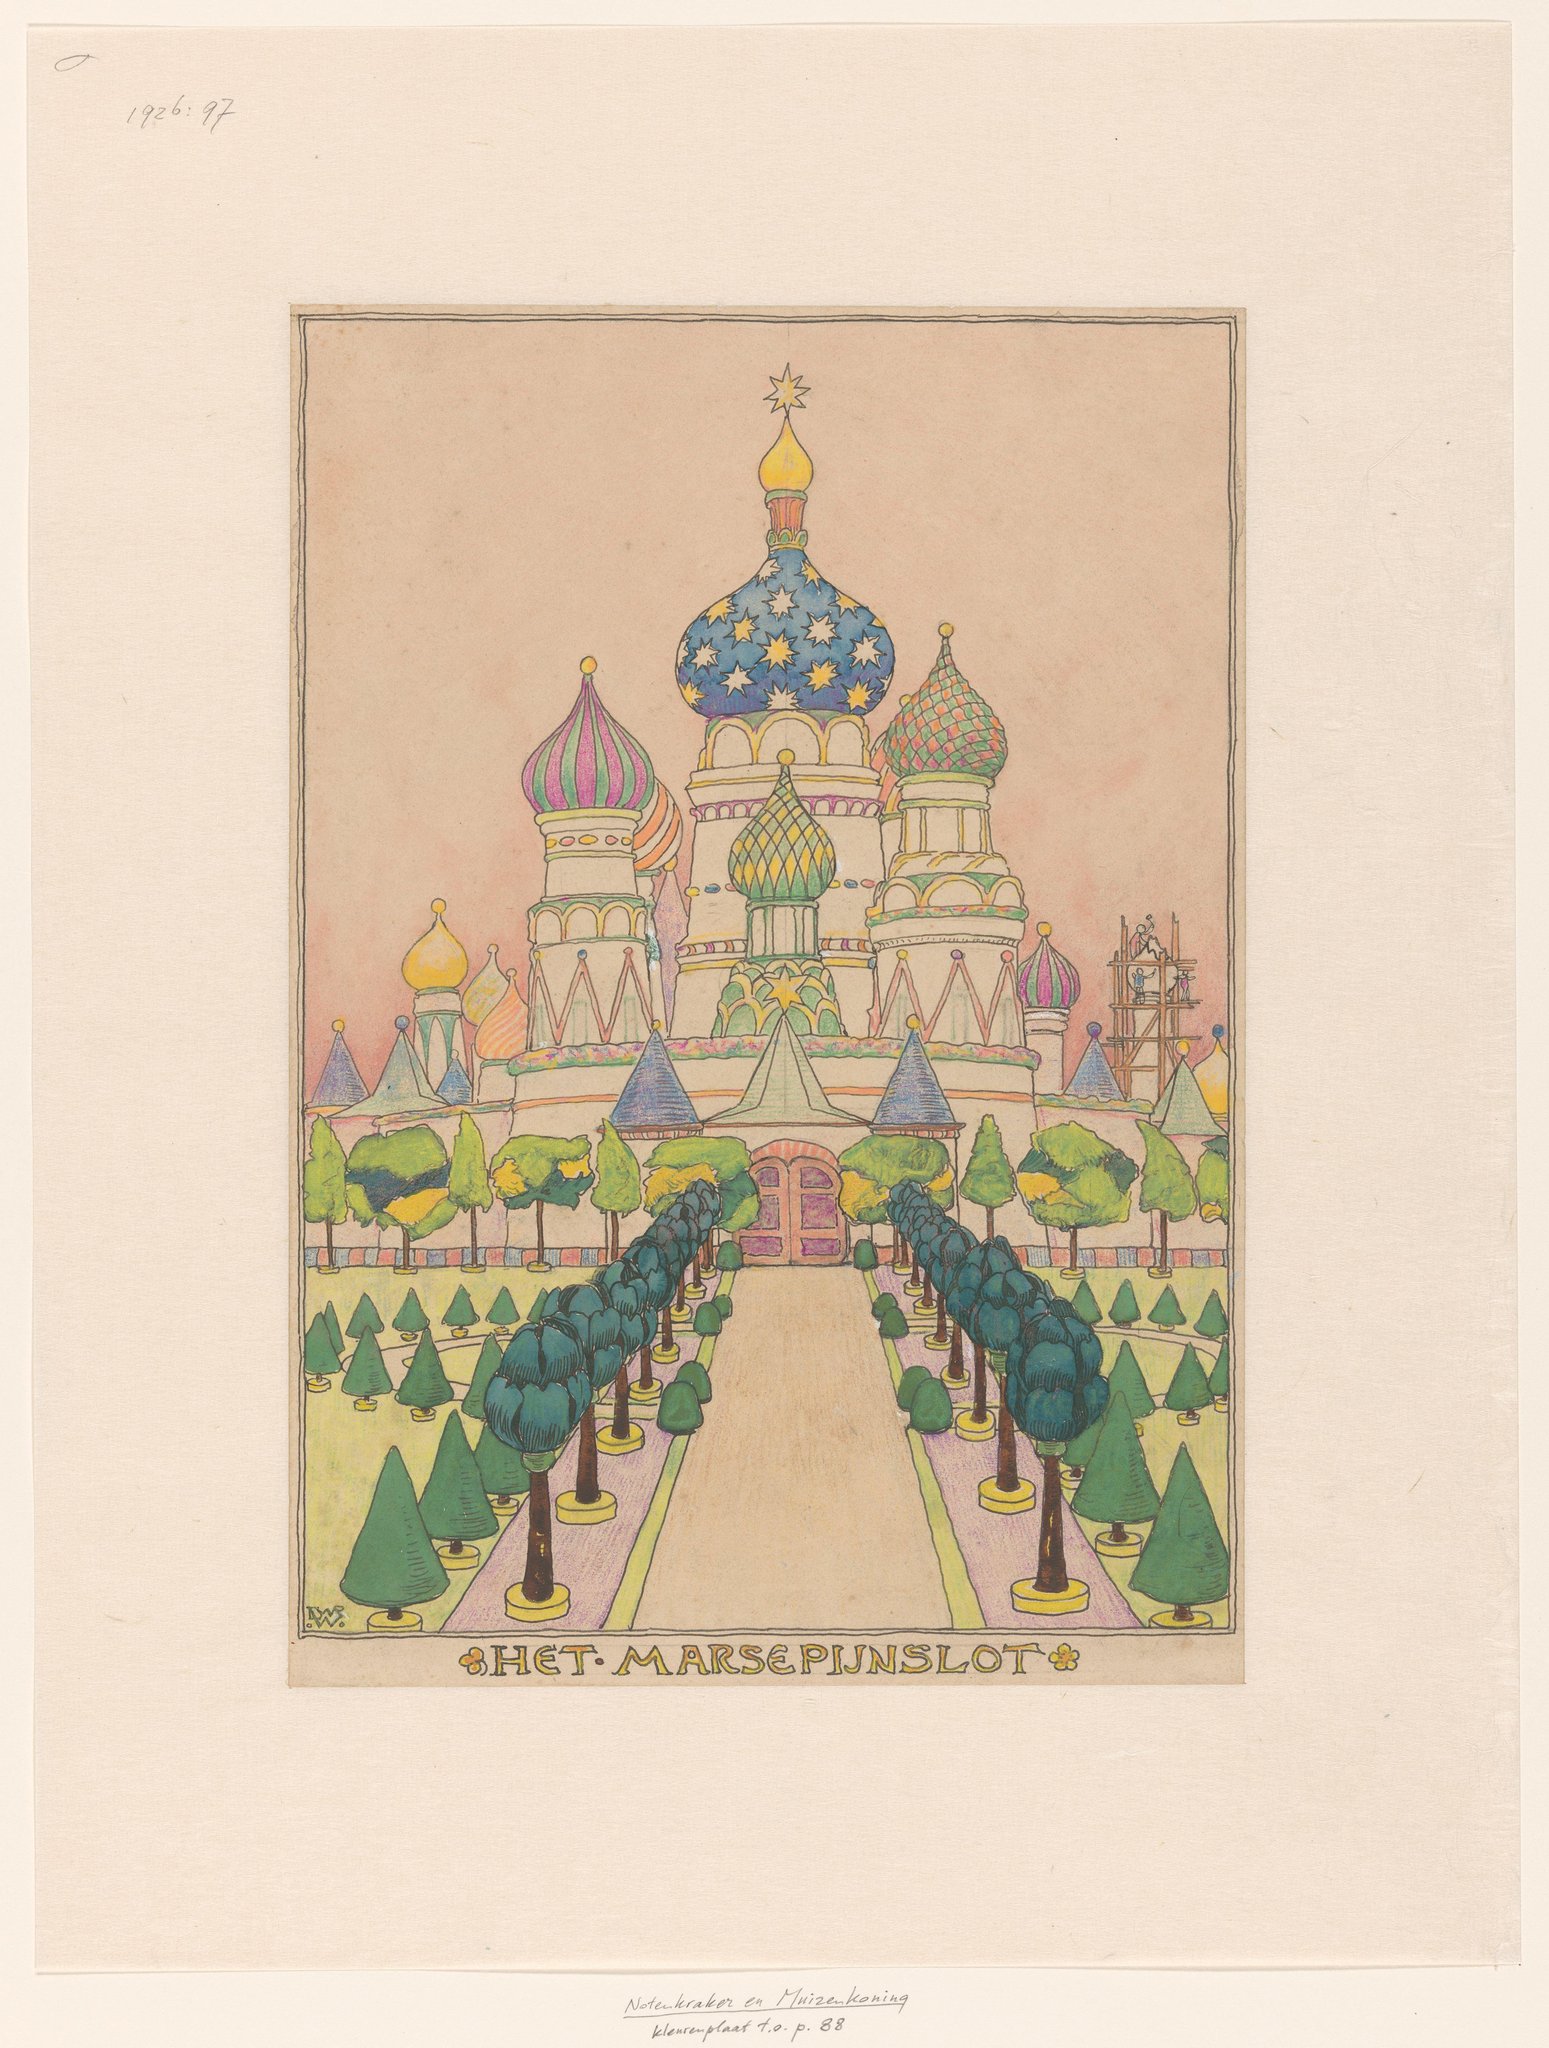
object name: boekillustratie ontwerp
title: Marsepeinslot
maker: willem wenckebach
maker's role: designer, draughtsman, painter, print maker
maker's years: 1860-1937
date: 1898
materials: chalk, paint, ink, paper, watercolor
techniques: brush, pen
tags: castle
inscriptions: number: ‘no. 182’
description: Kasteel met uienkoepels in verschillende groottes, kleuren en patronen. Een oprijlaan met bomen leidt naar de voordeur. Rechts in de achtergrond wordt aan de constructie van een nieuwe koepel gewerkt.